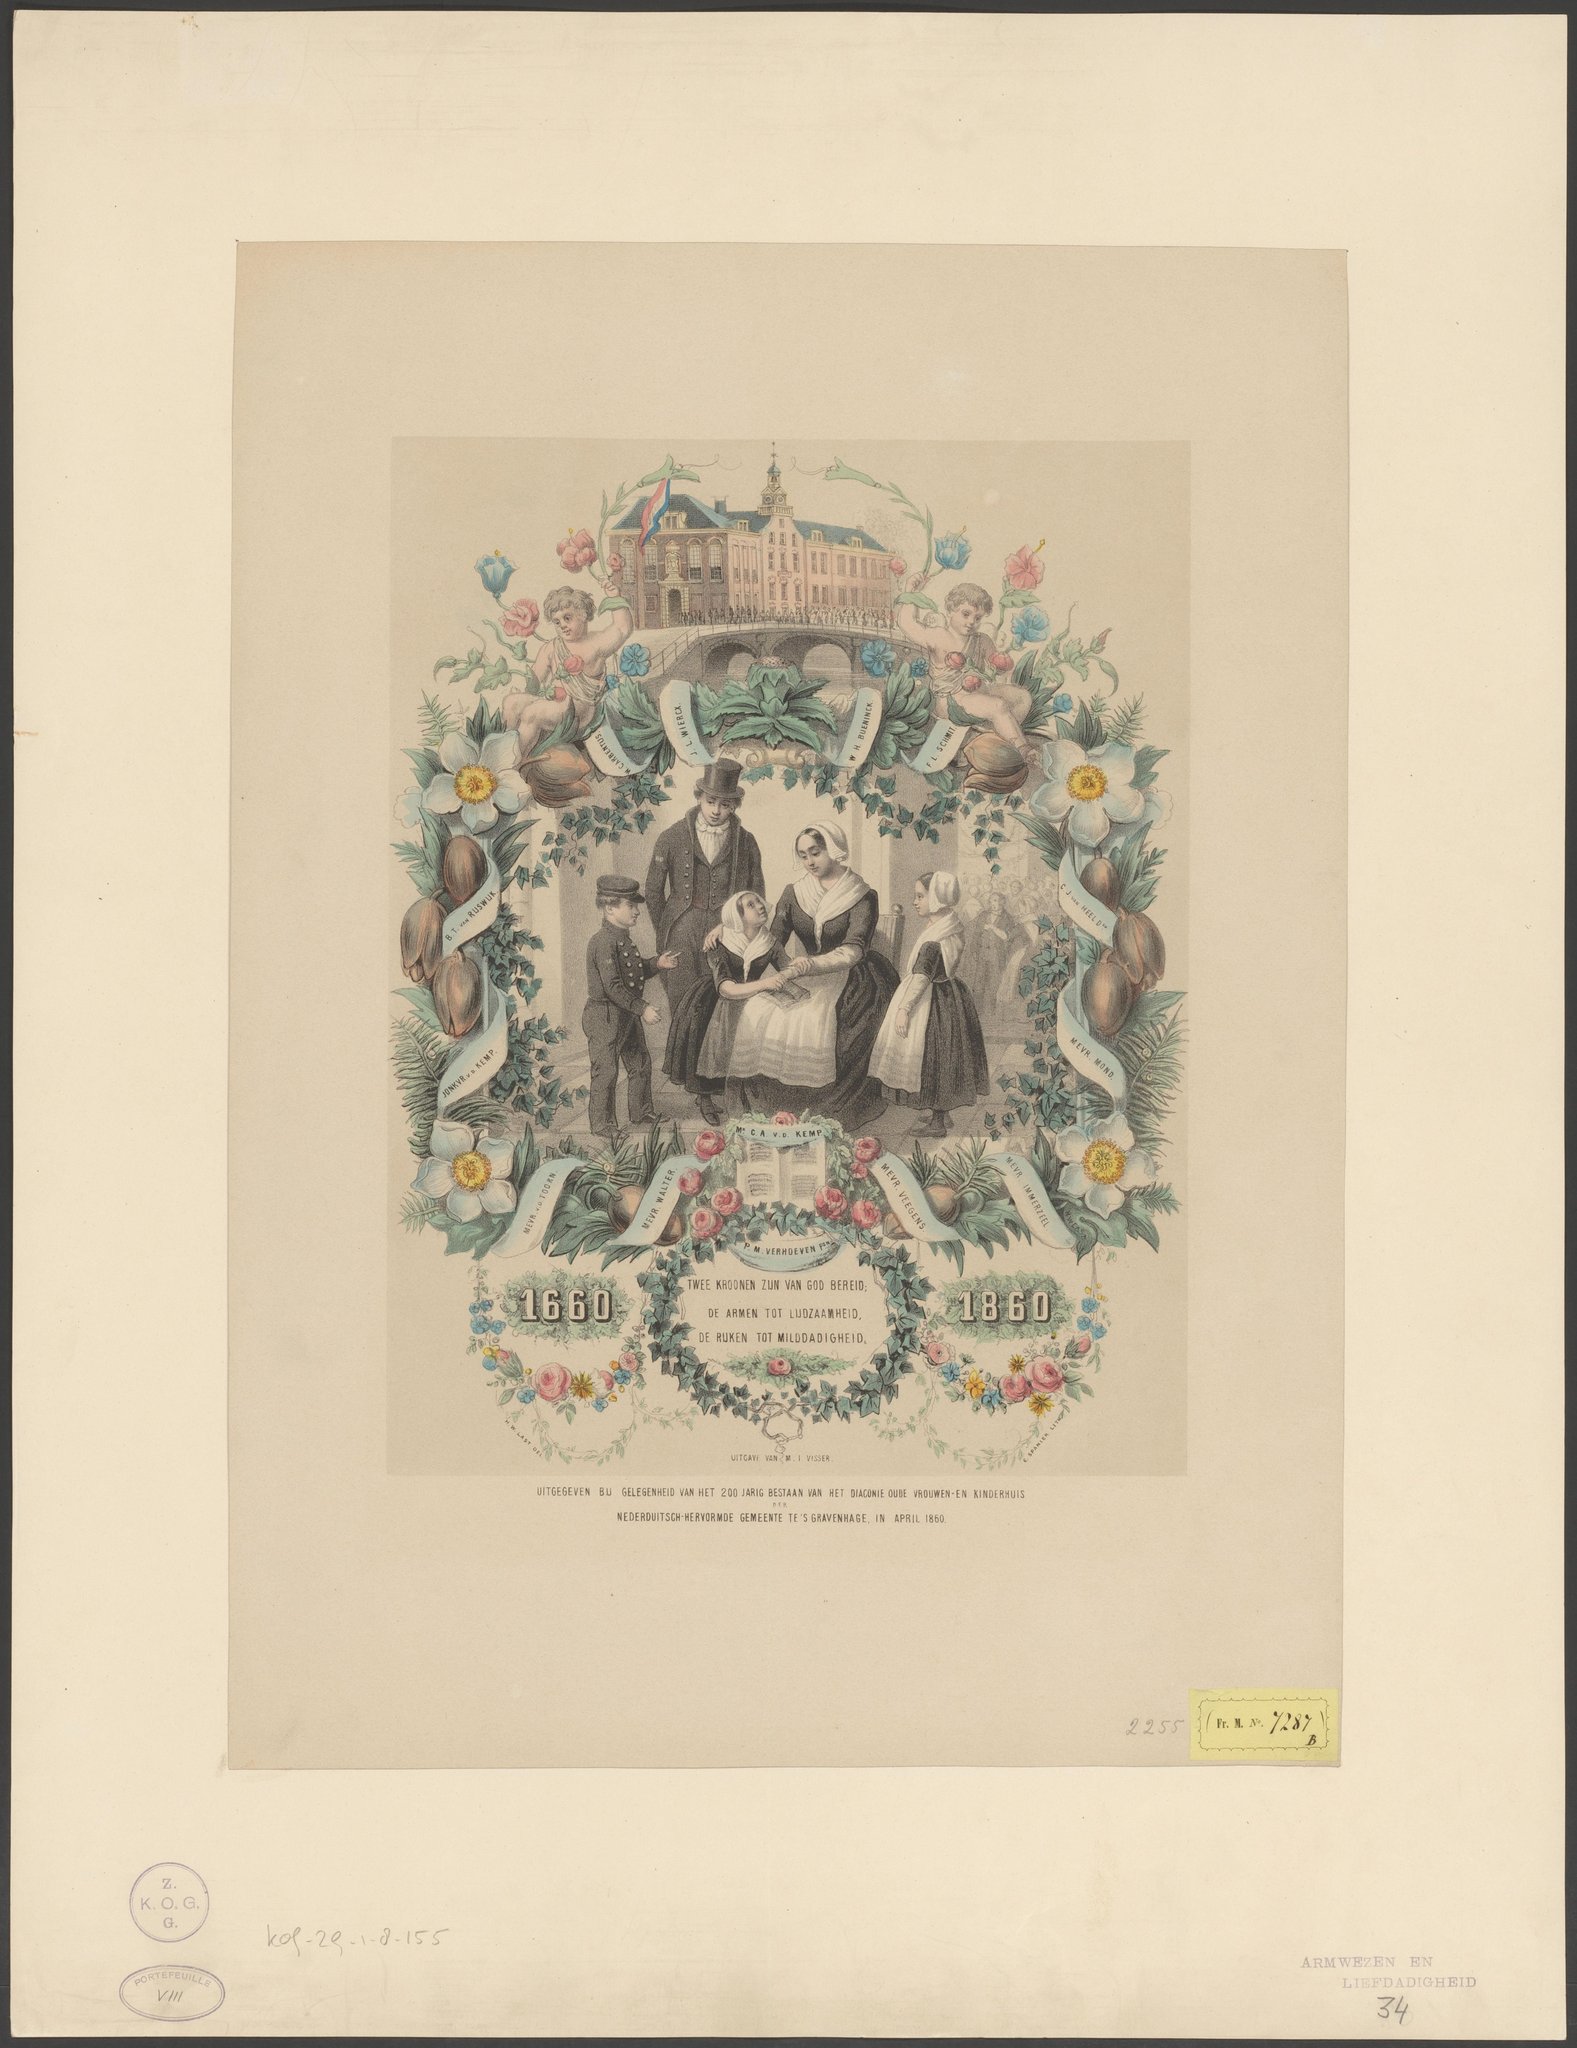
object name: print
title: Tweede eeuwfeest van het Diaconie Oude Vrouwen- en Kinderhuis in Den Haag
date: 1860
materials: paper, watercolor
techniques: hand coloring, lithograph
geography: netherlands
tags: orphanage, charitable works, old-people's home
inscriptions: collector's mark: Lugt 1641, label: ‘Fr. M. No. 7287B’, collector's mark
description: Enkele kinderen en hun verzorgers, in een bloemenkrans met de namen van de begunstigers. Bovenaan een gezicht op het gebouw. Bij het tweede eeuwfeest van het Diaconie Oude Vrouwen- en Kinderhuis van de Nederduits Hervormde Gemeente in Den Haag in 1860. Onderwerpsrubrieken binnen de Atlas Zeden en Gewoonten: Armwezen en Liefdadigheid.